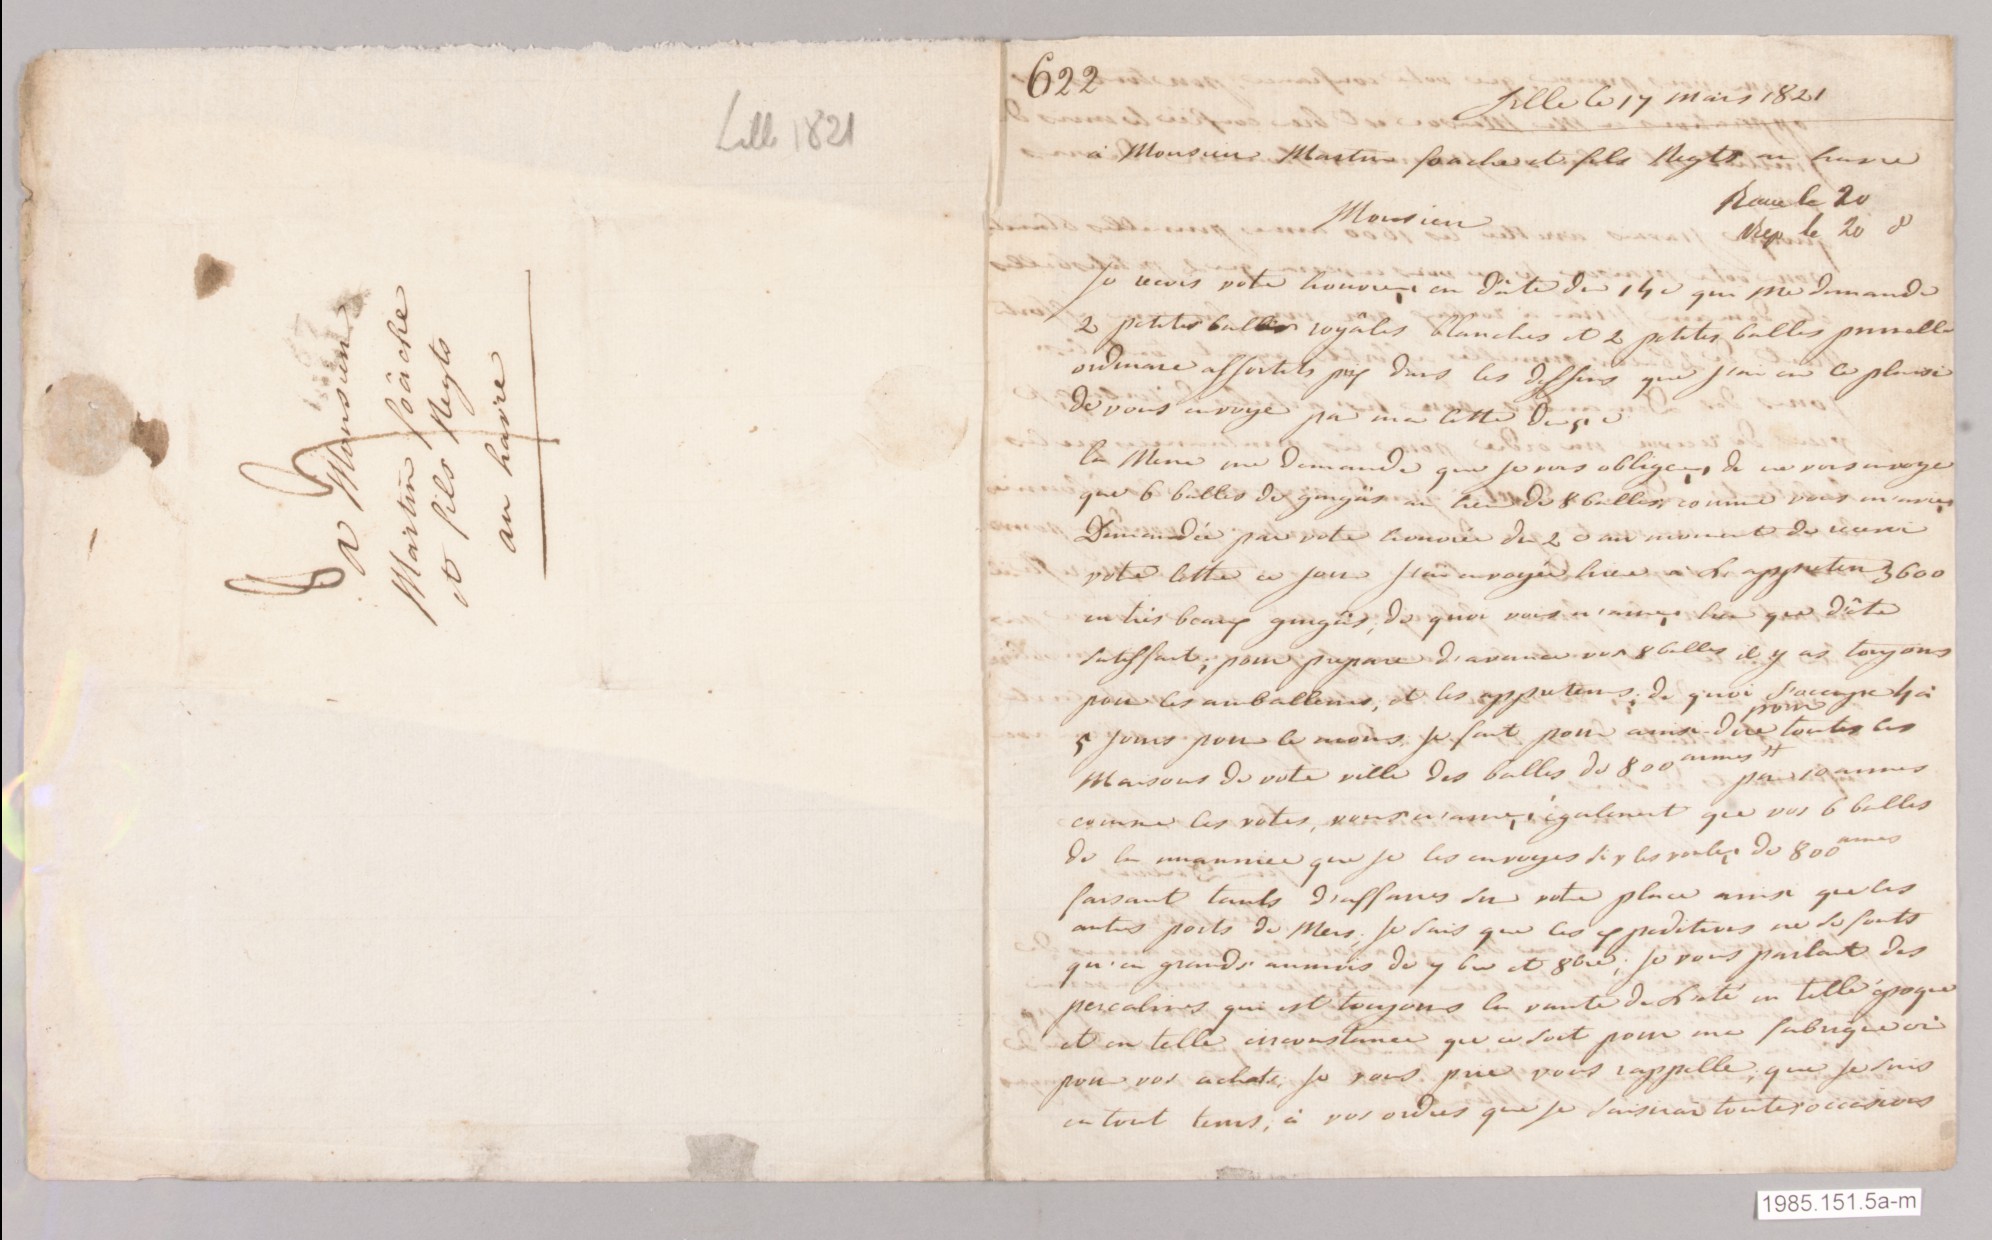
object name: letter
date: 1801-1833